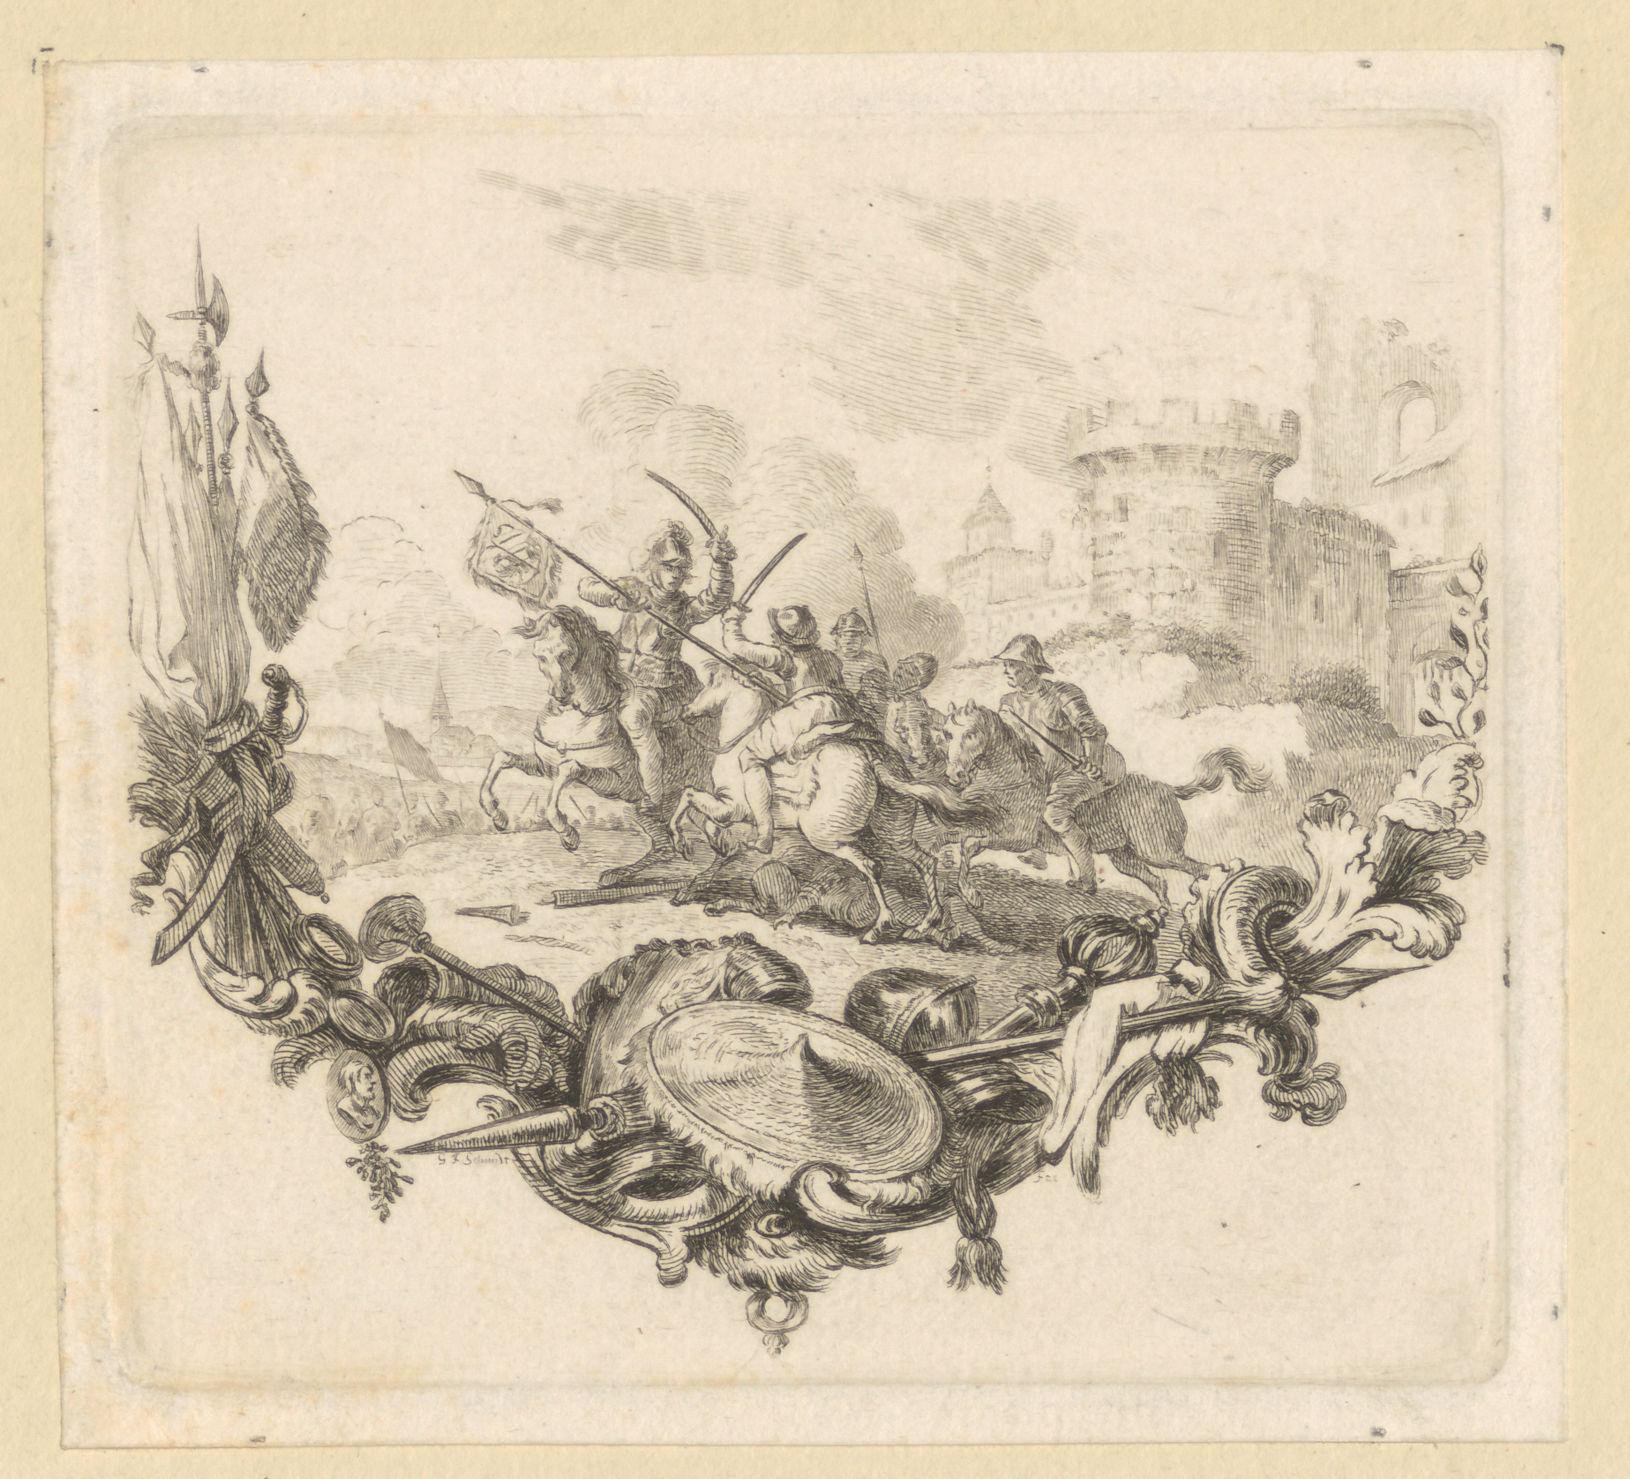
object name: print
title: Gevecht om de vlag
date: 1751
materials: paper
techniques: etching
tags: historical events and situations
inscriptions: collector's mark: Lugt 240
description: Prent ook gebruikt in: Frederik de Grote. Mémoires pour servir a l'histoire de la maison de Brandebourg. Sanssouci, Frederik de Grote, 1751.